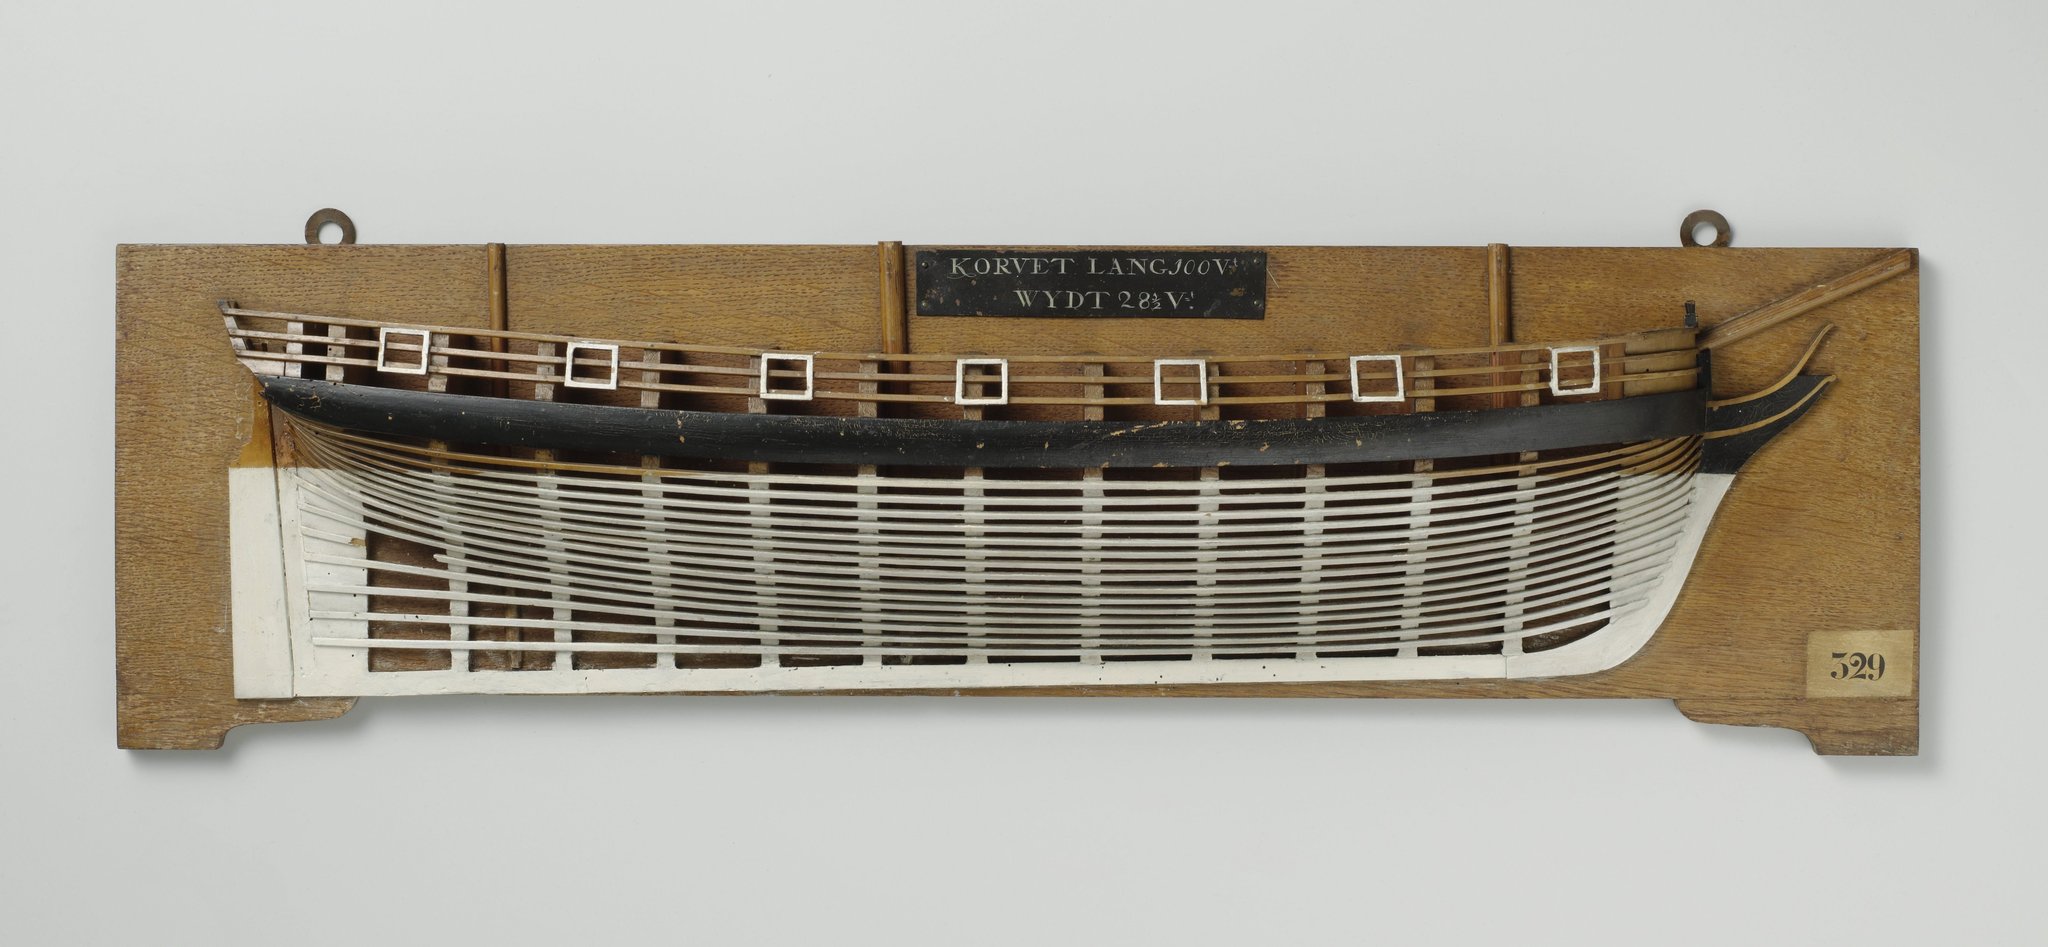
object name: builder's model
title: Half Model of a 14-Gun Sloop of War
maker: Anonymous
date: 1780-1820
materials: wood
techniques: polychromy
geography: netherlands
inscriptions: inscription, top centre, on a rectangular black label: ‘KORVET LANG 100 Vt / WYDT 28½ Vt.’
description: Gepolychromeerd mallenmodel (stuurboord) van een driemaster. Zeven geschutpoorten aangegeven op één dek. Gewrongen spiegel, hol wulf, geen details van het hek, geen zijgalerij; recht roer met vierkante roerkoning. Zeeg voor en achter iets oplopend, één barkhout. Gepiekt rondspant. Schaal ca. 1:40 (schaal op model).